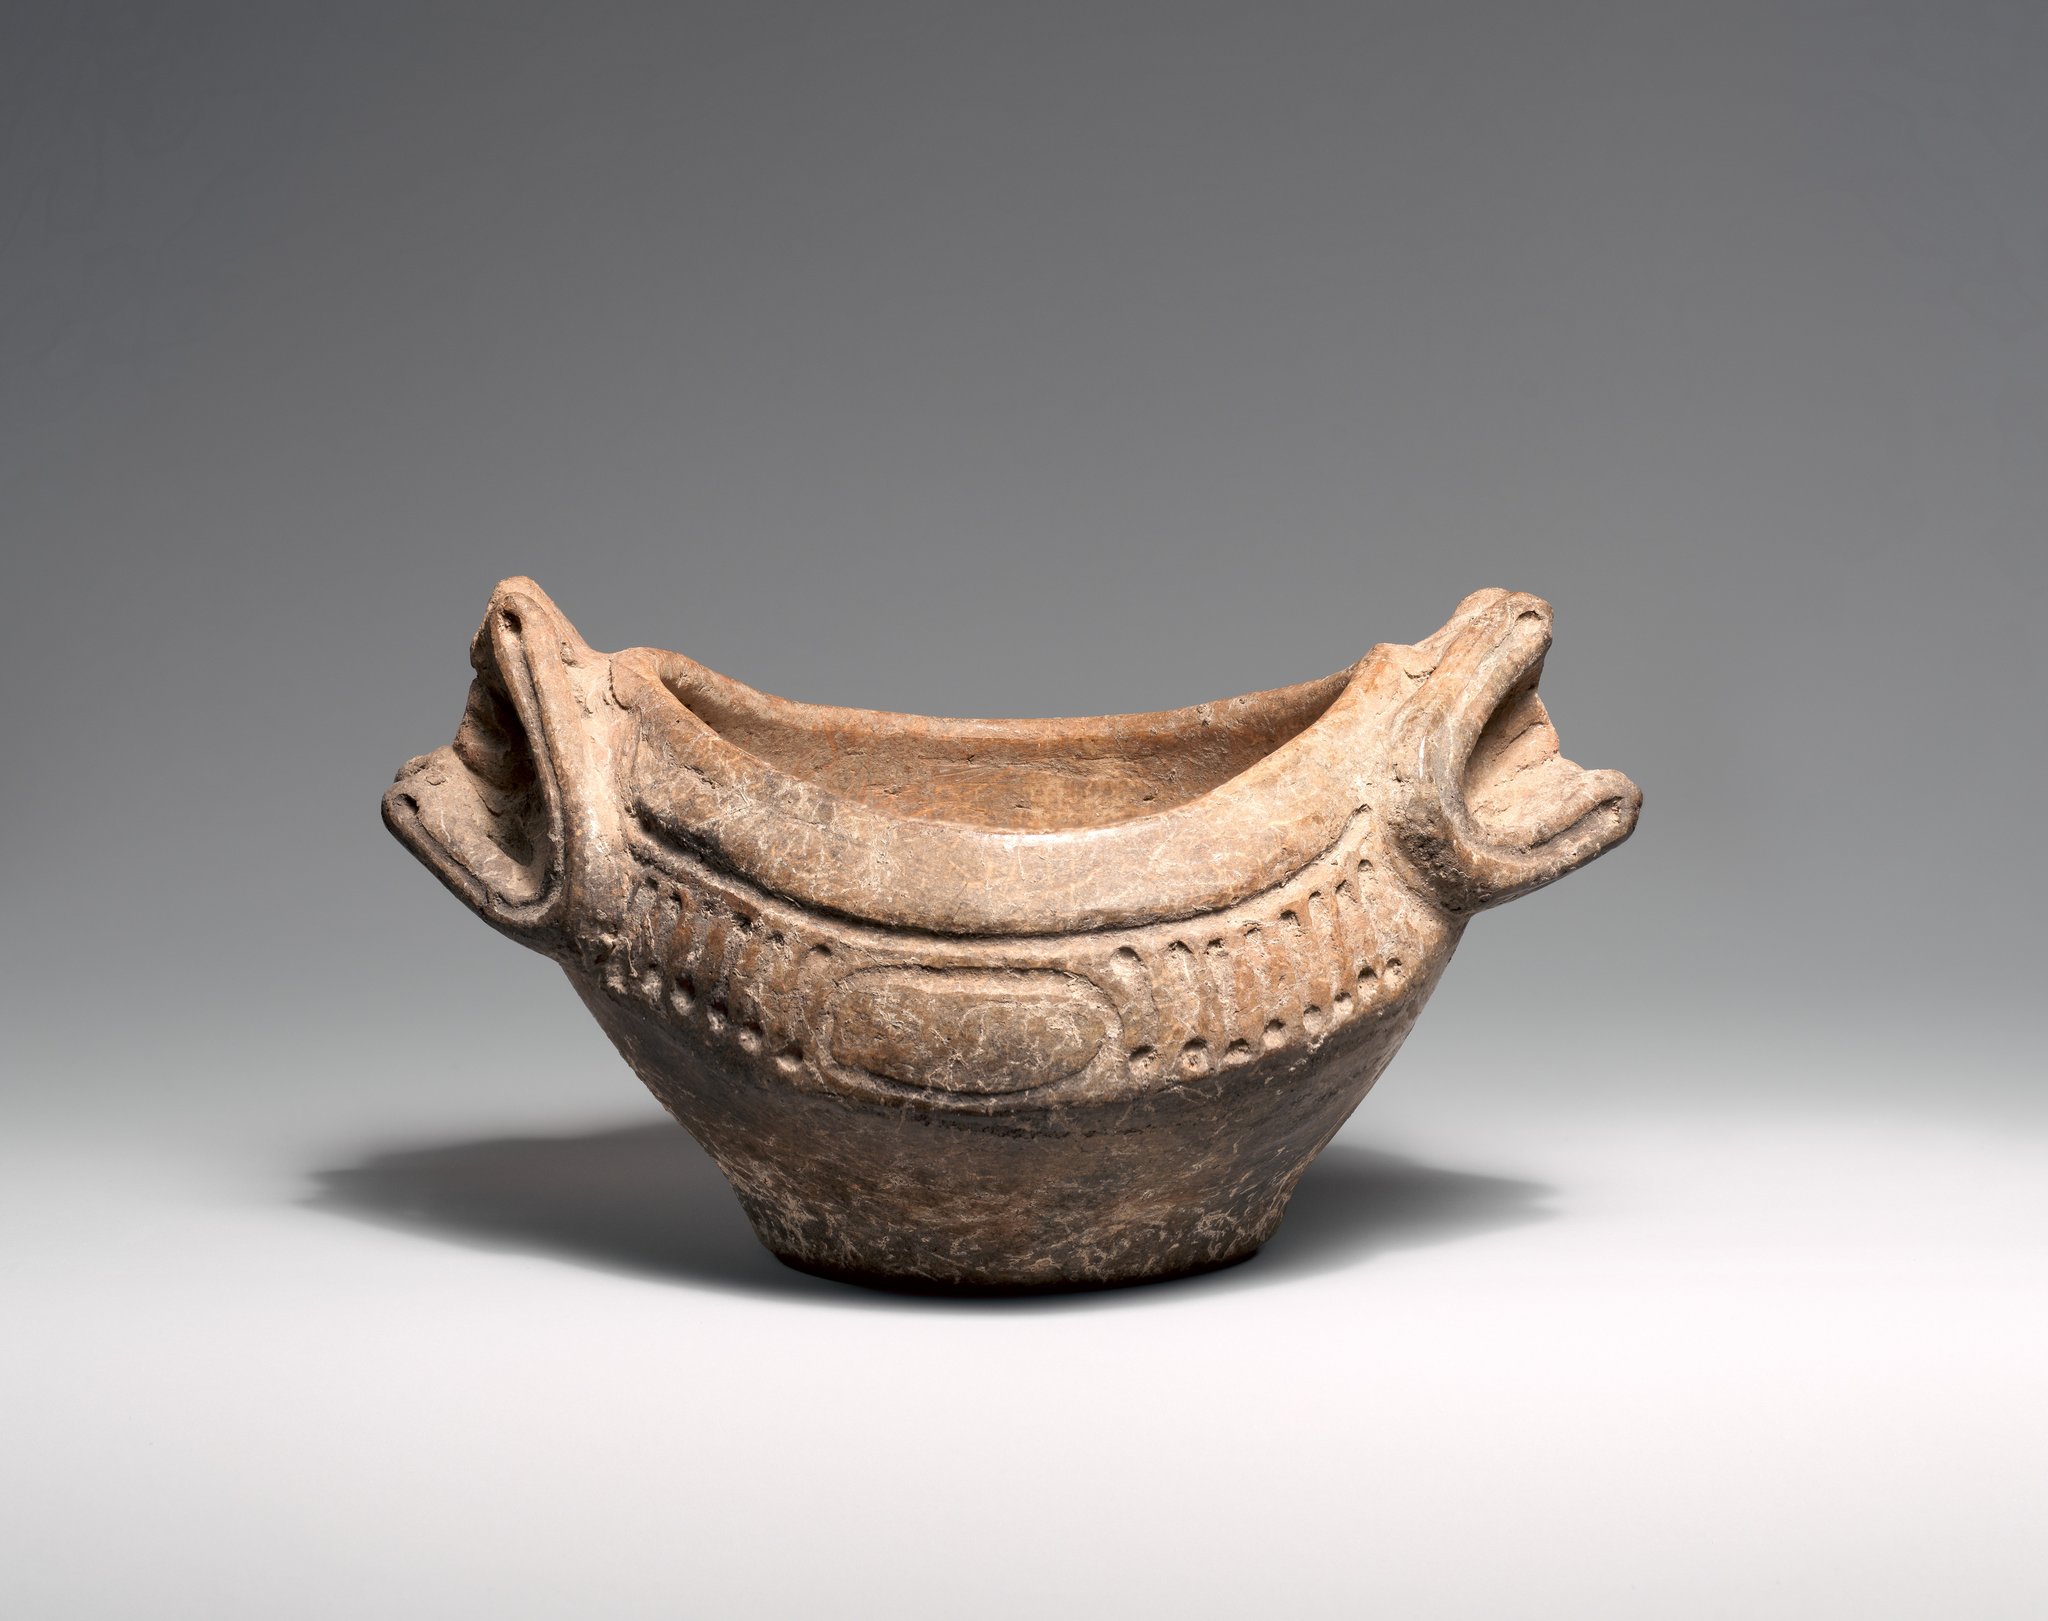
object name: bowl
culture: taíno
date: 1201-1500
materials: ceramic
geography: dominican republic